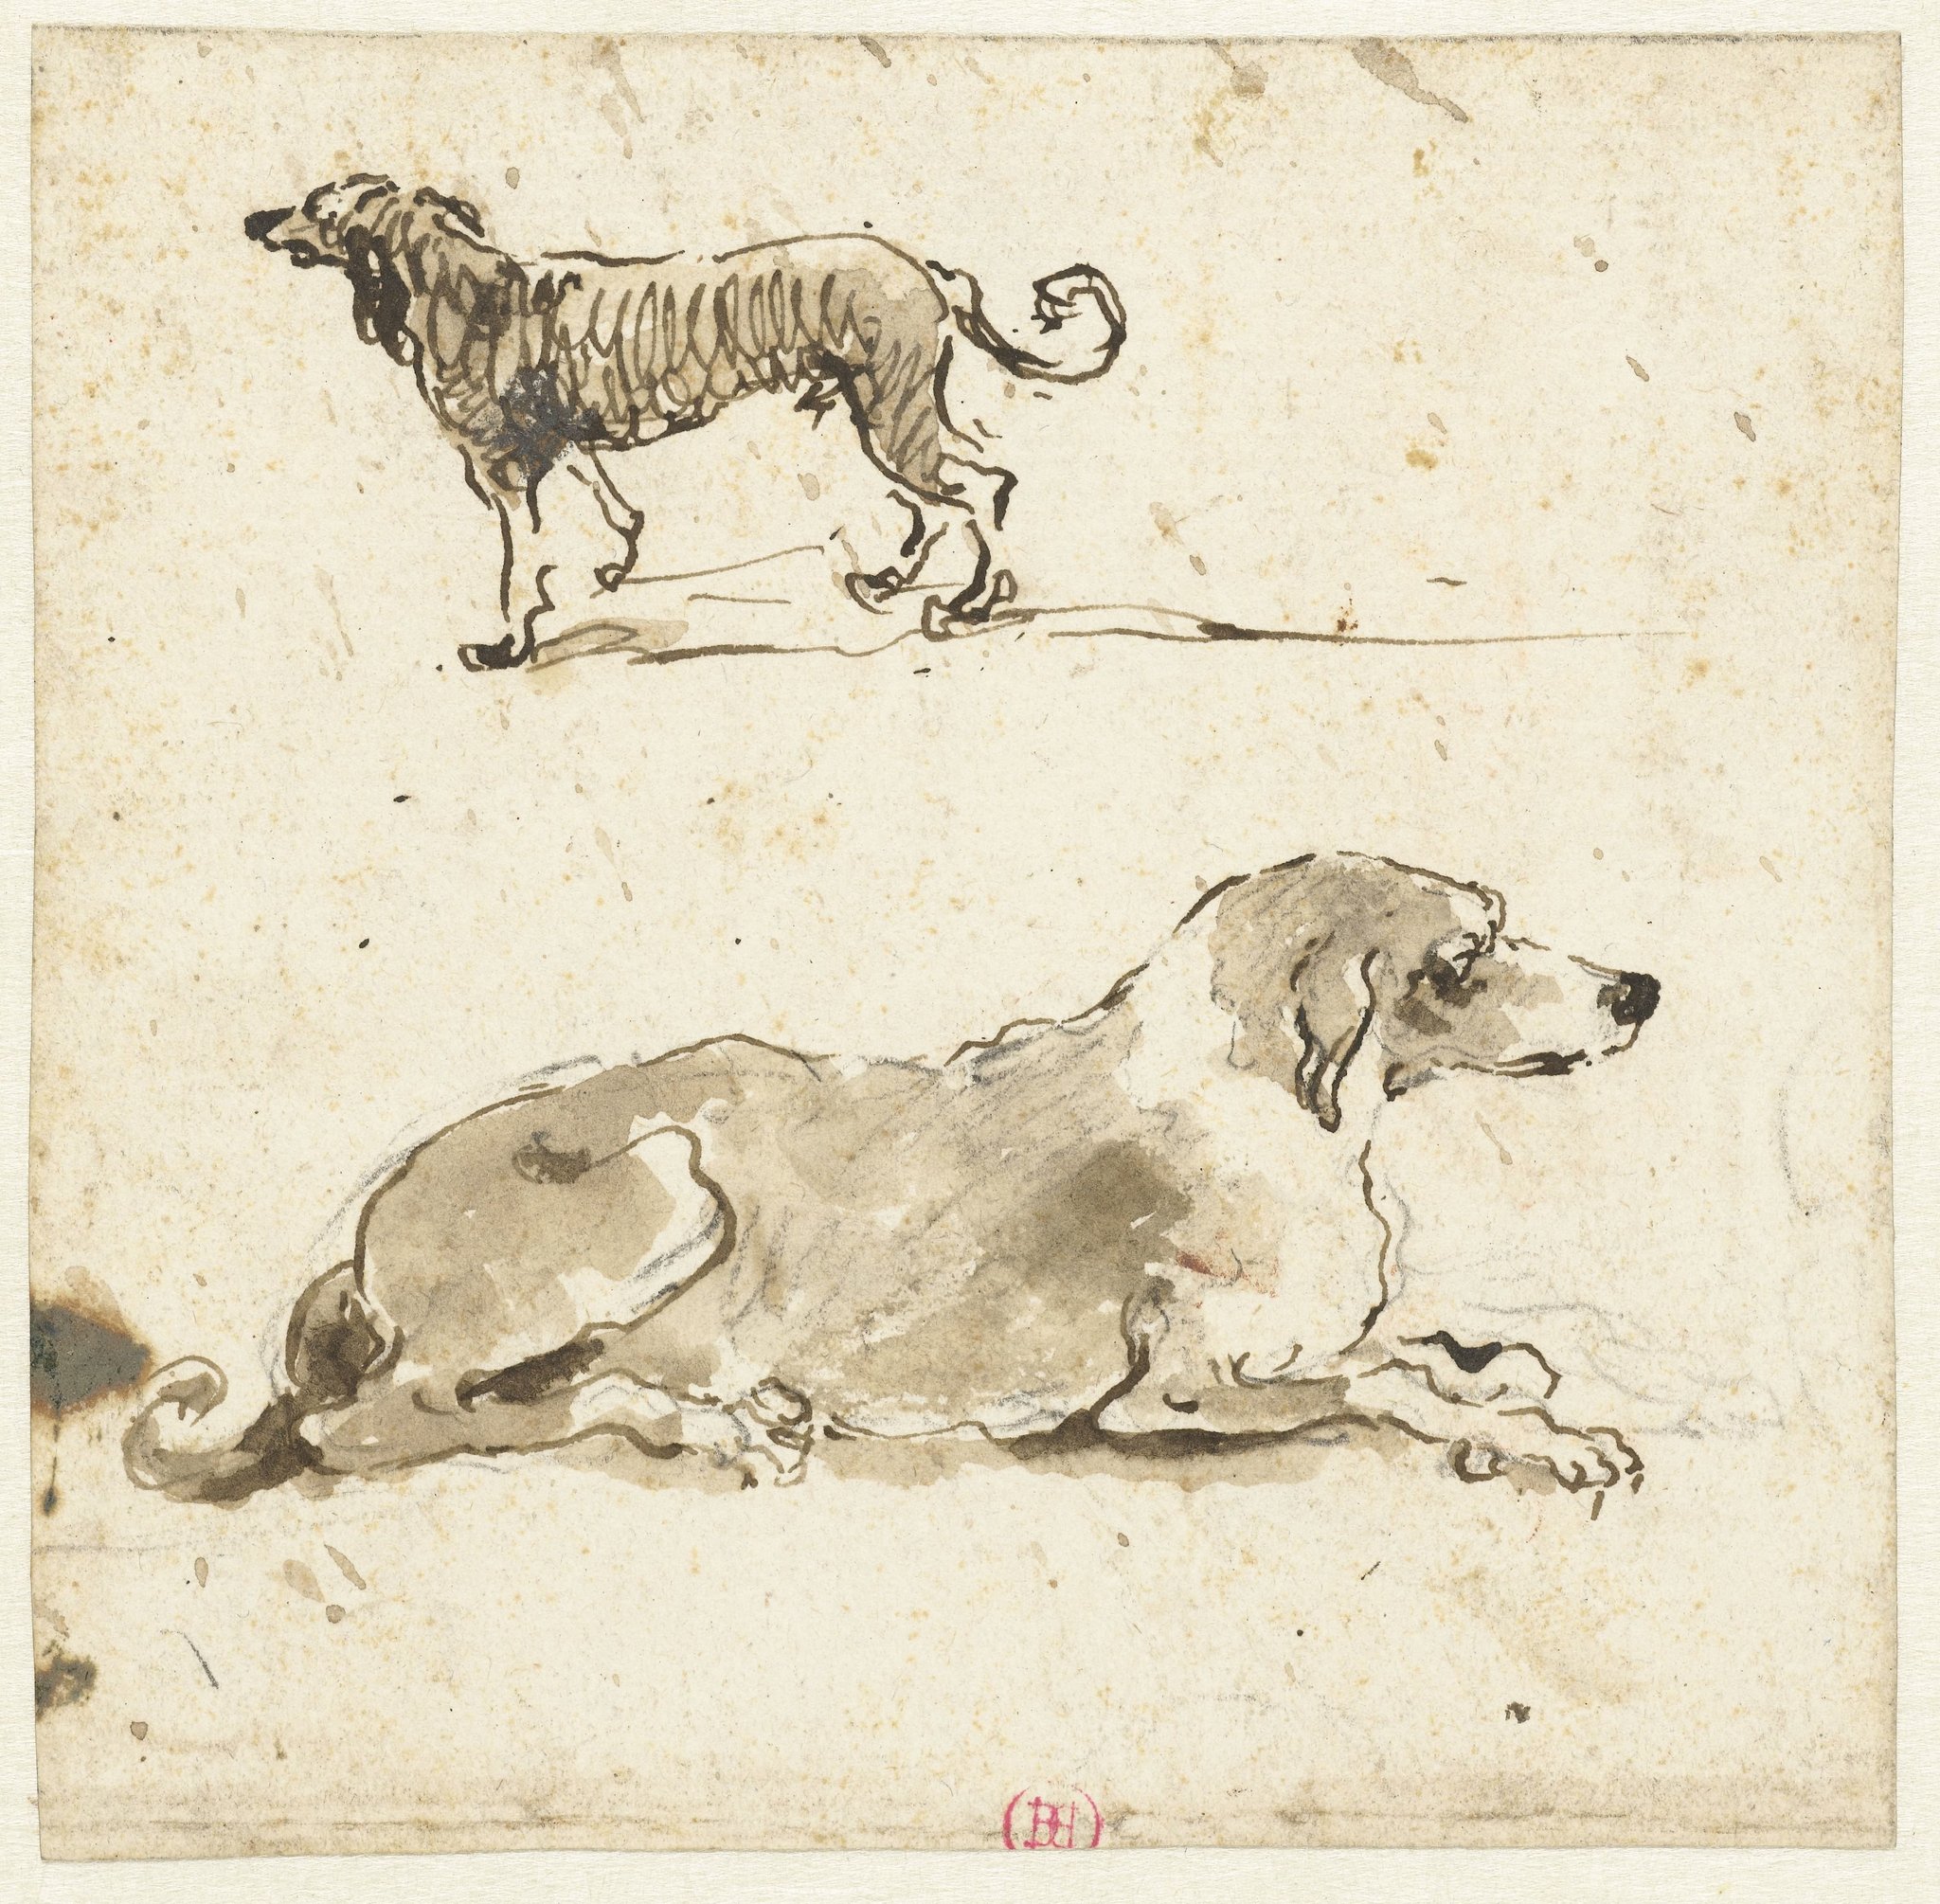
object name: drawing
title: Liggende en een lopende hond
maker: francesco guardi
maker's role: draughtsman, painter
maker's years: 1712-1792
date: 1722-1792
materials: ink, paper, pencil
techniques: brush, pen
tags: dog